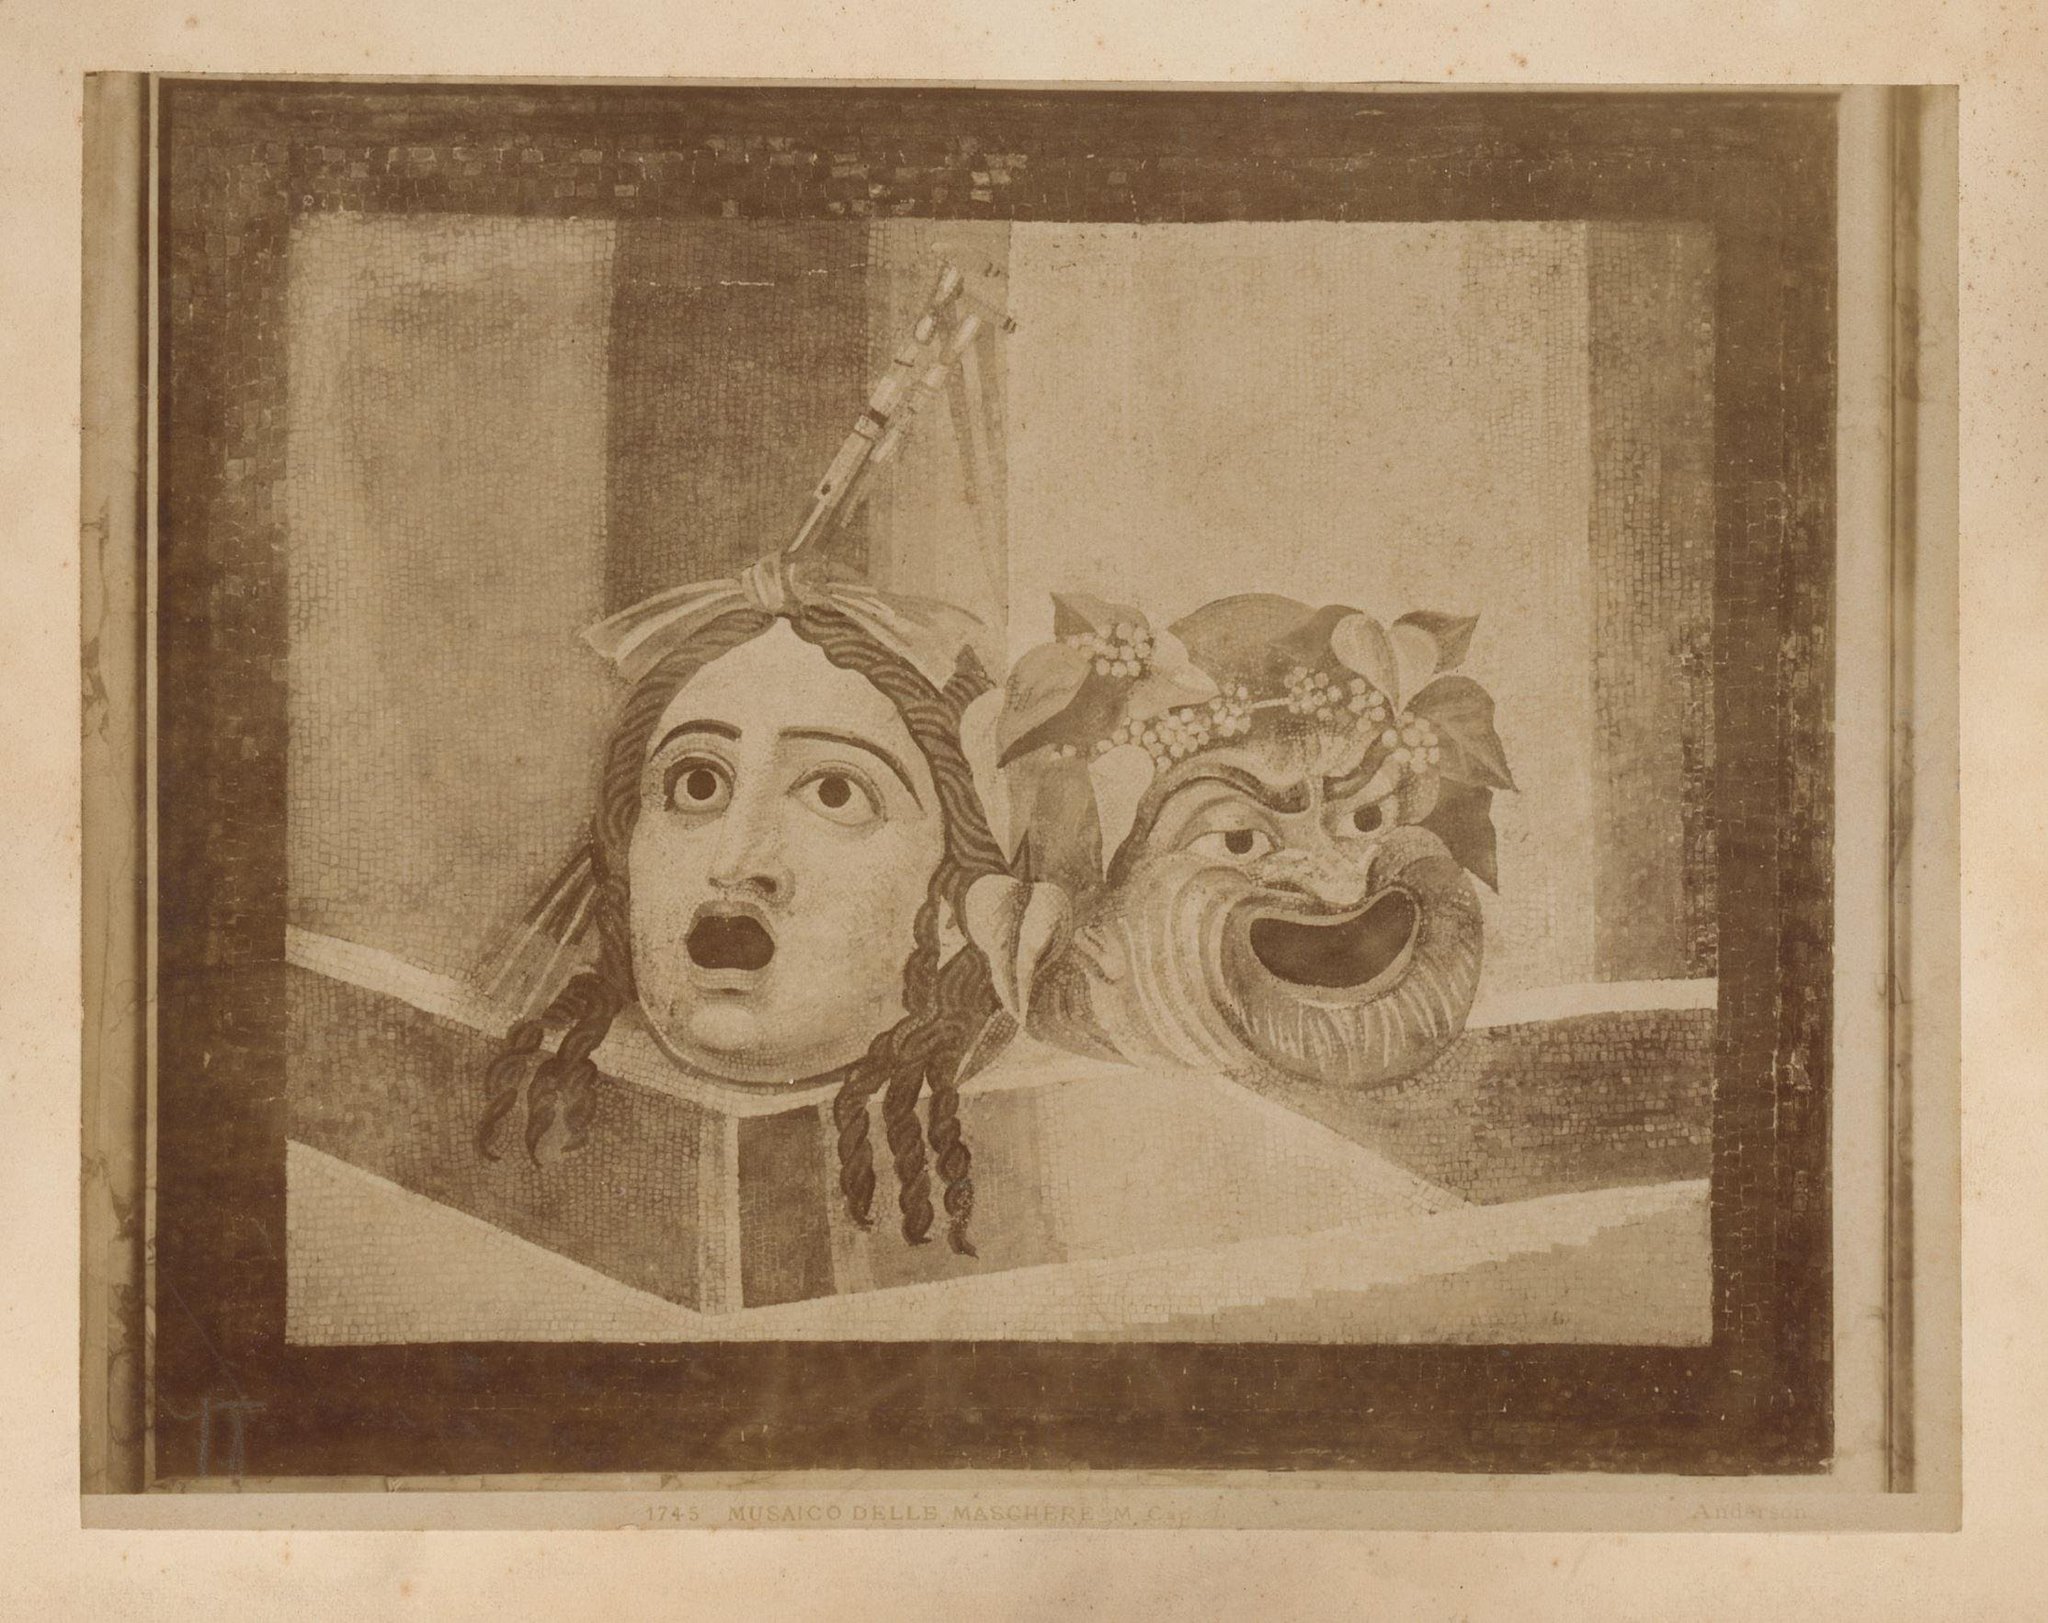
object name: album leaf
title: Fotoreproductie van mozaïek met maskers in de Capitolijnse Musea te Rome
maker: james anderson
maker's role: fotograaf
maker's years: 1813-1877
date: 1857-1875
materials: paper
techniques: albumen print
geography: capitolijnse musea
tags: mask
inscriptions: inscription: ‘1745. Musaico delle Maschere M. Cap. Anderson’